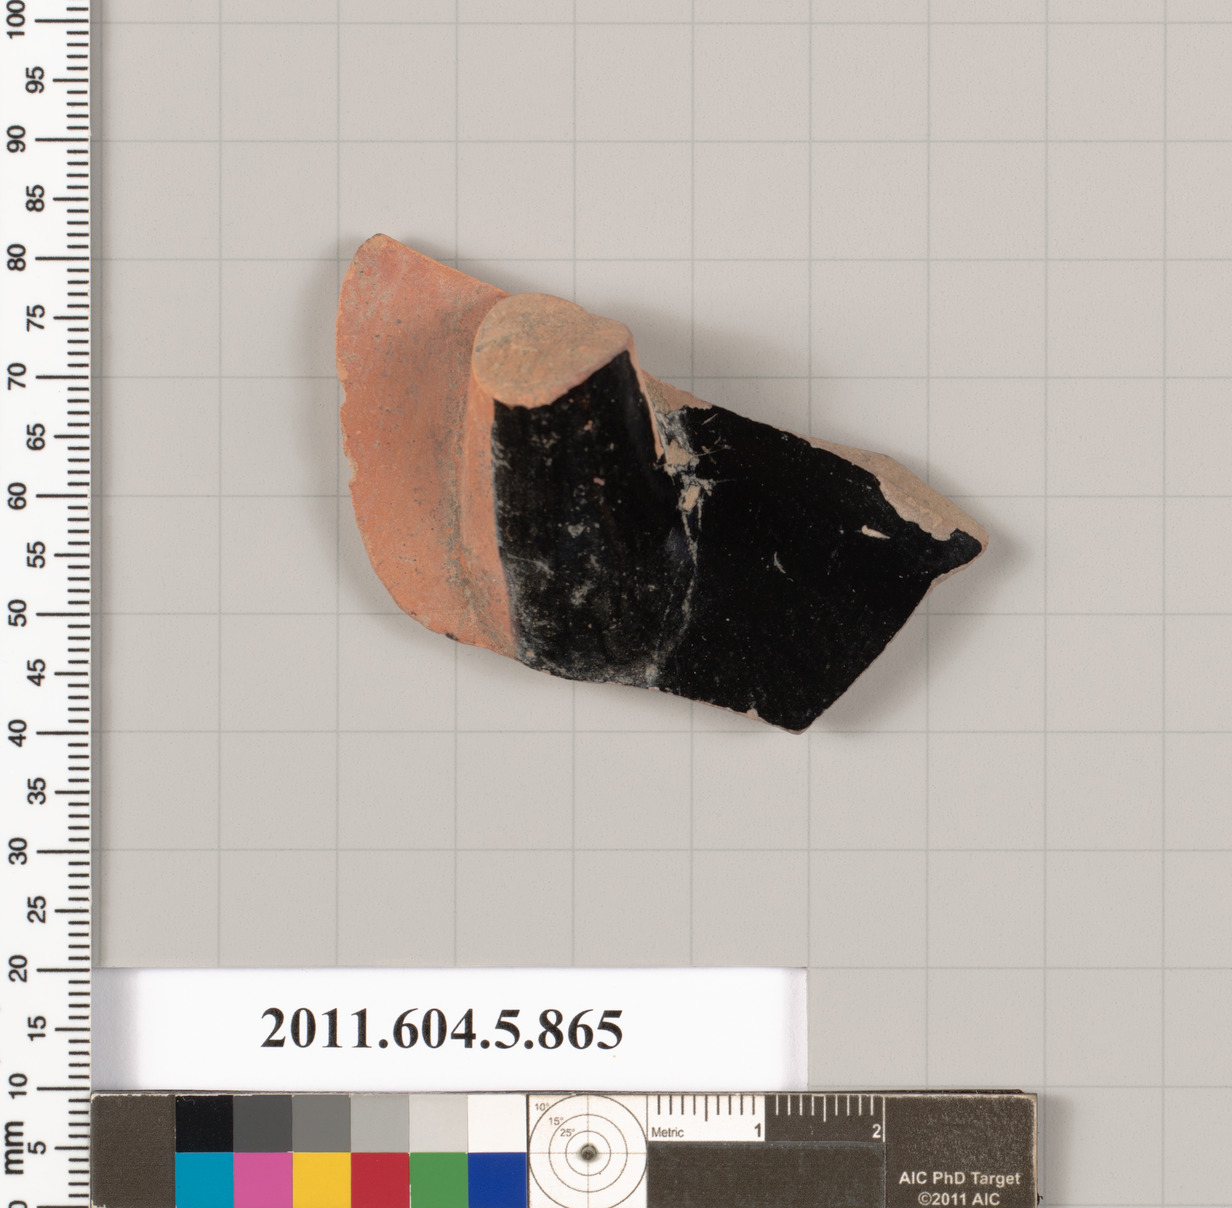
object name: kylix fragment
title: Terracotta fragment of a kylix (drinking cup)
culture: greek, attic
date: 600-401 BCE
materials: terracotta